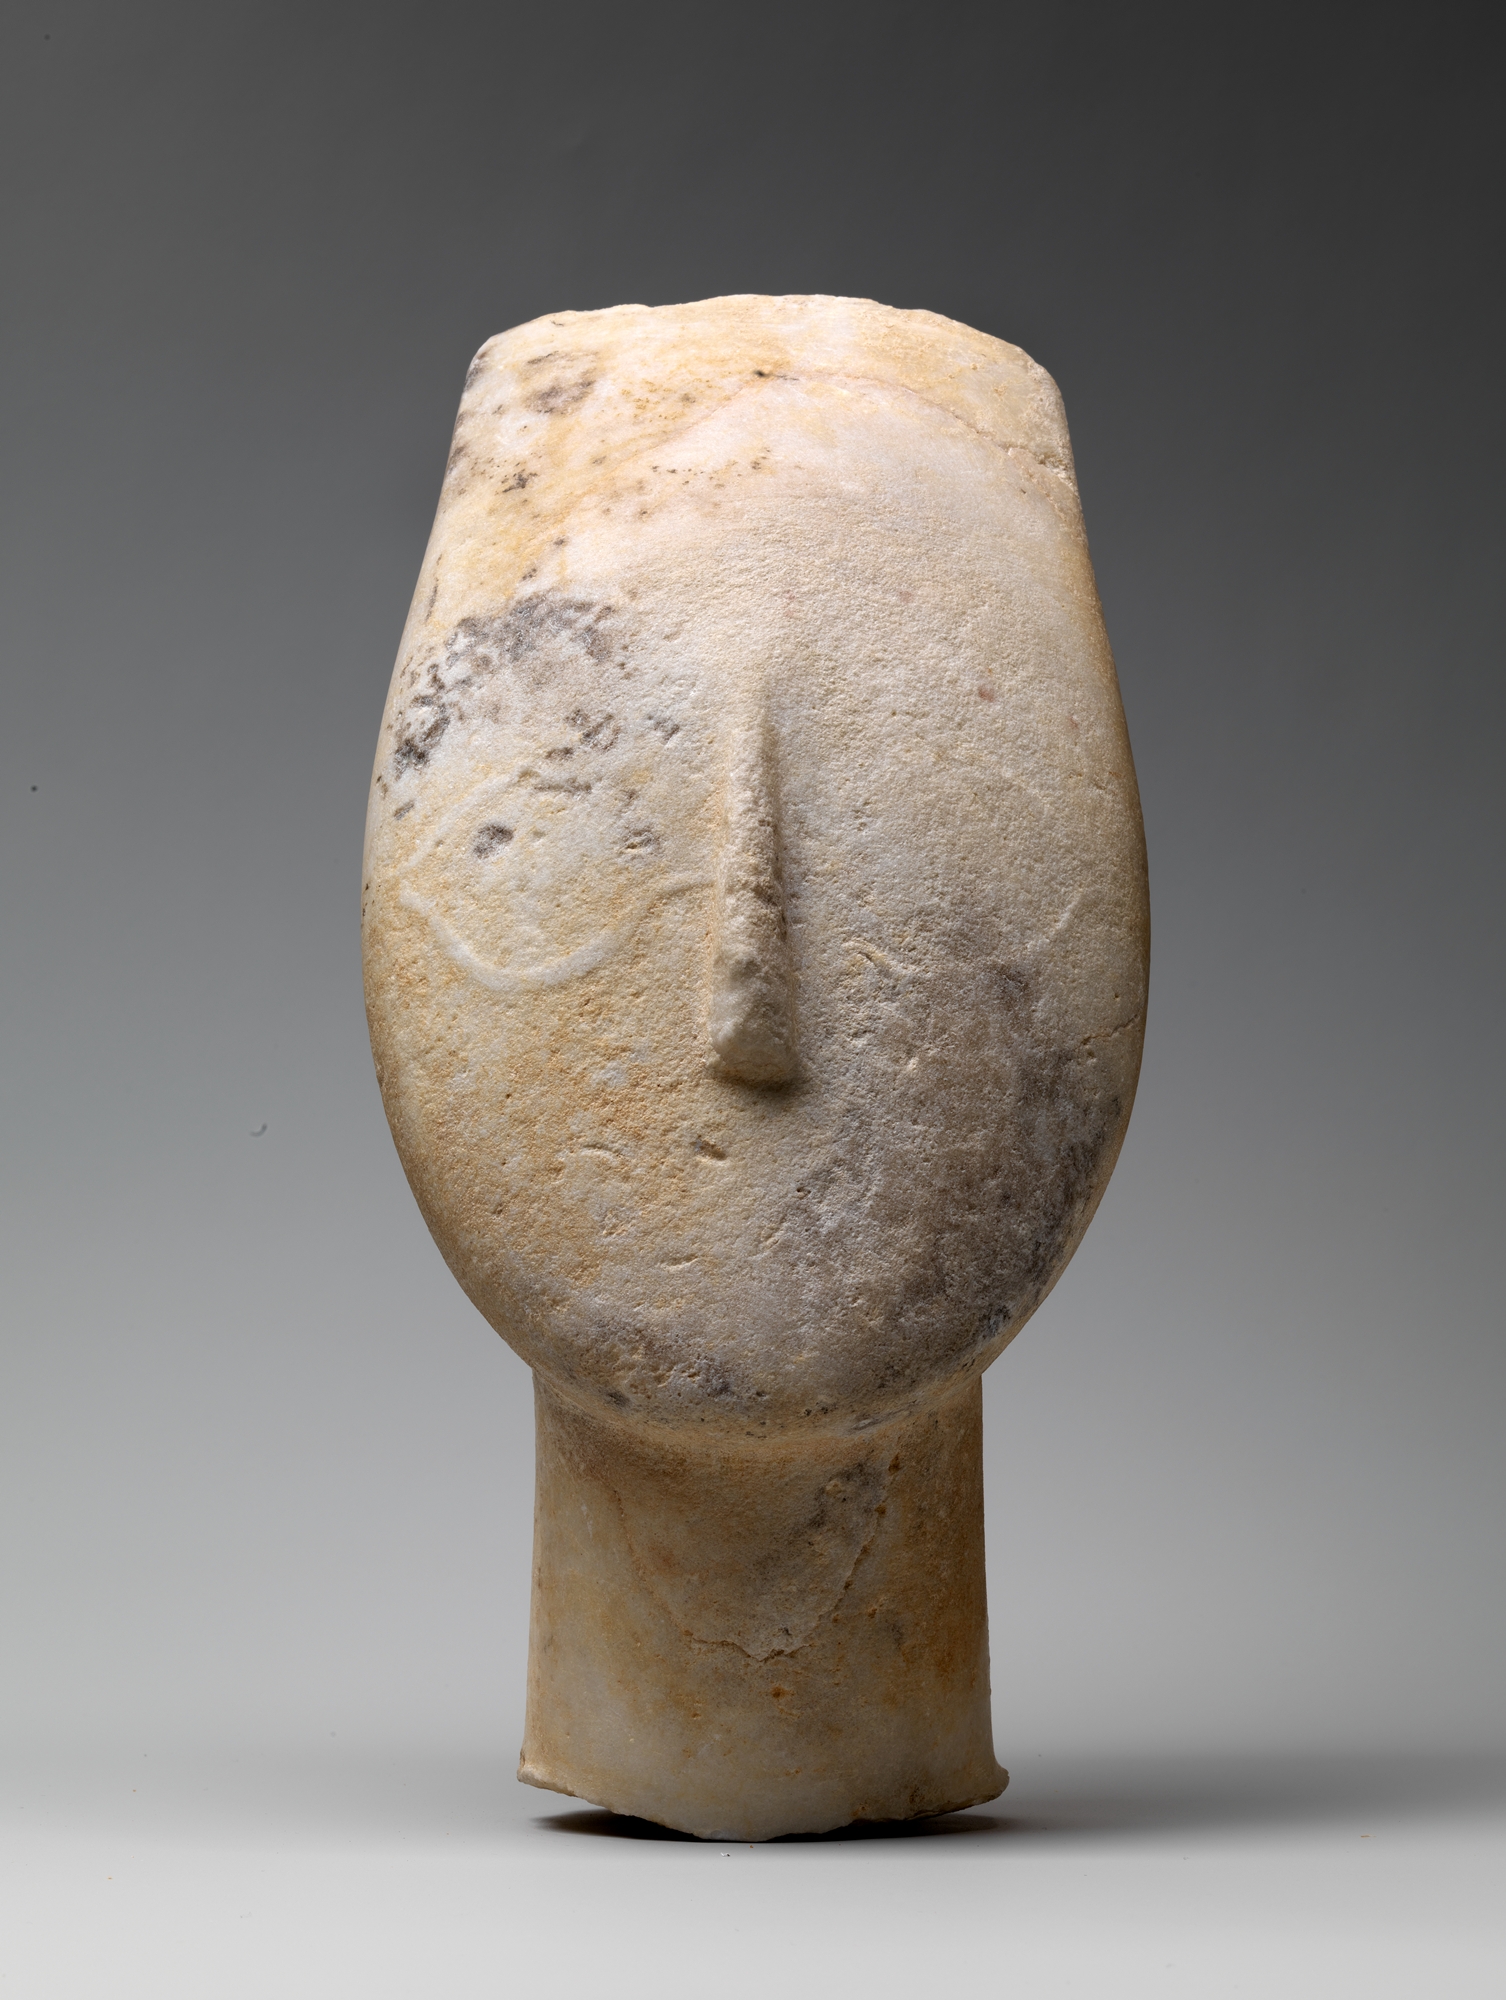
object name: head of a woman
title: Marble head from the figure of a woman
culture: cycladic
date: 2700-2500 BCE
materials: marble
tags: heads,women